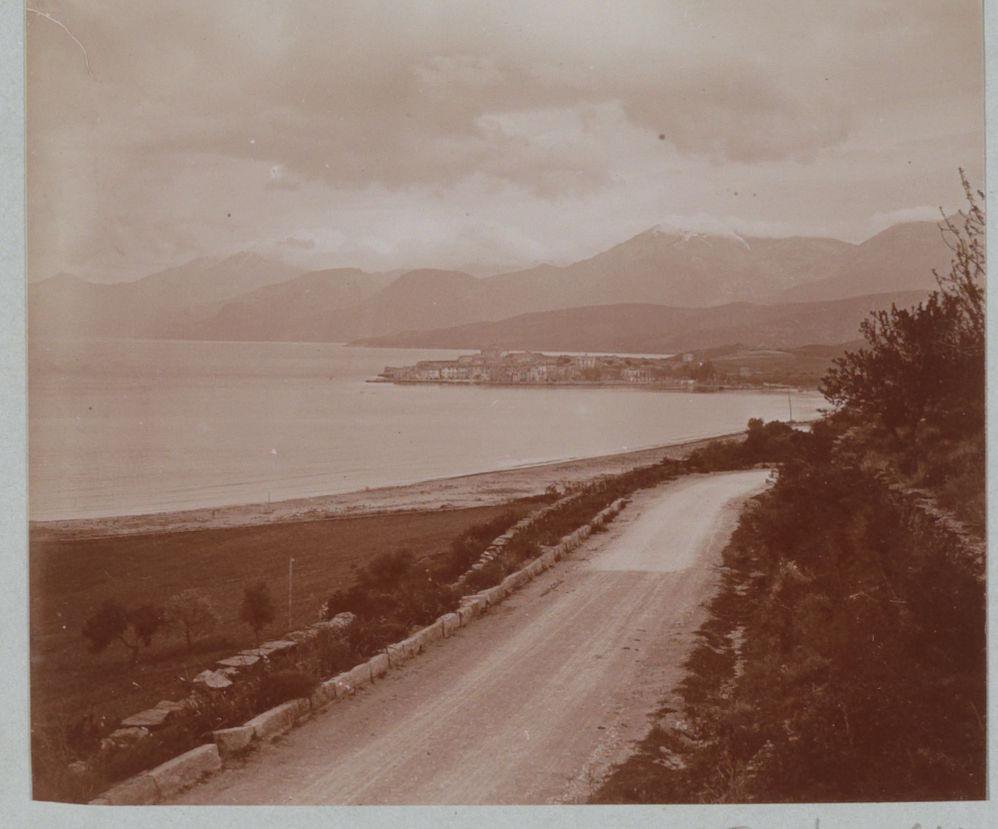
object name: photograph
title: Gezicht op een kuststrook van Corsica met op de achtergrond een stad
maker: Anonymous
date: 1905-1910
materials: paper, photographic support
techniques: gelatin silver print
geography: corsica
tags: coast, prospect of city, town panorama, silhouette of city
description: Onderdeel van Fotoalbum van een Franse amateurfotograaf met bezienswaardigheden in Frankrijk, Zwitserland en Italië.